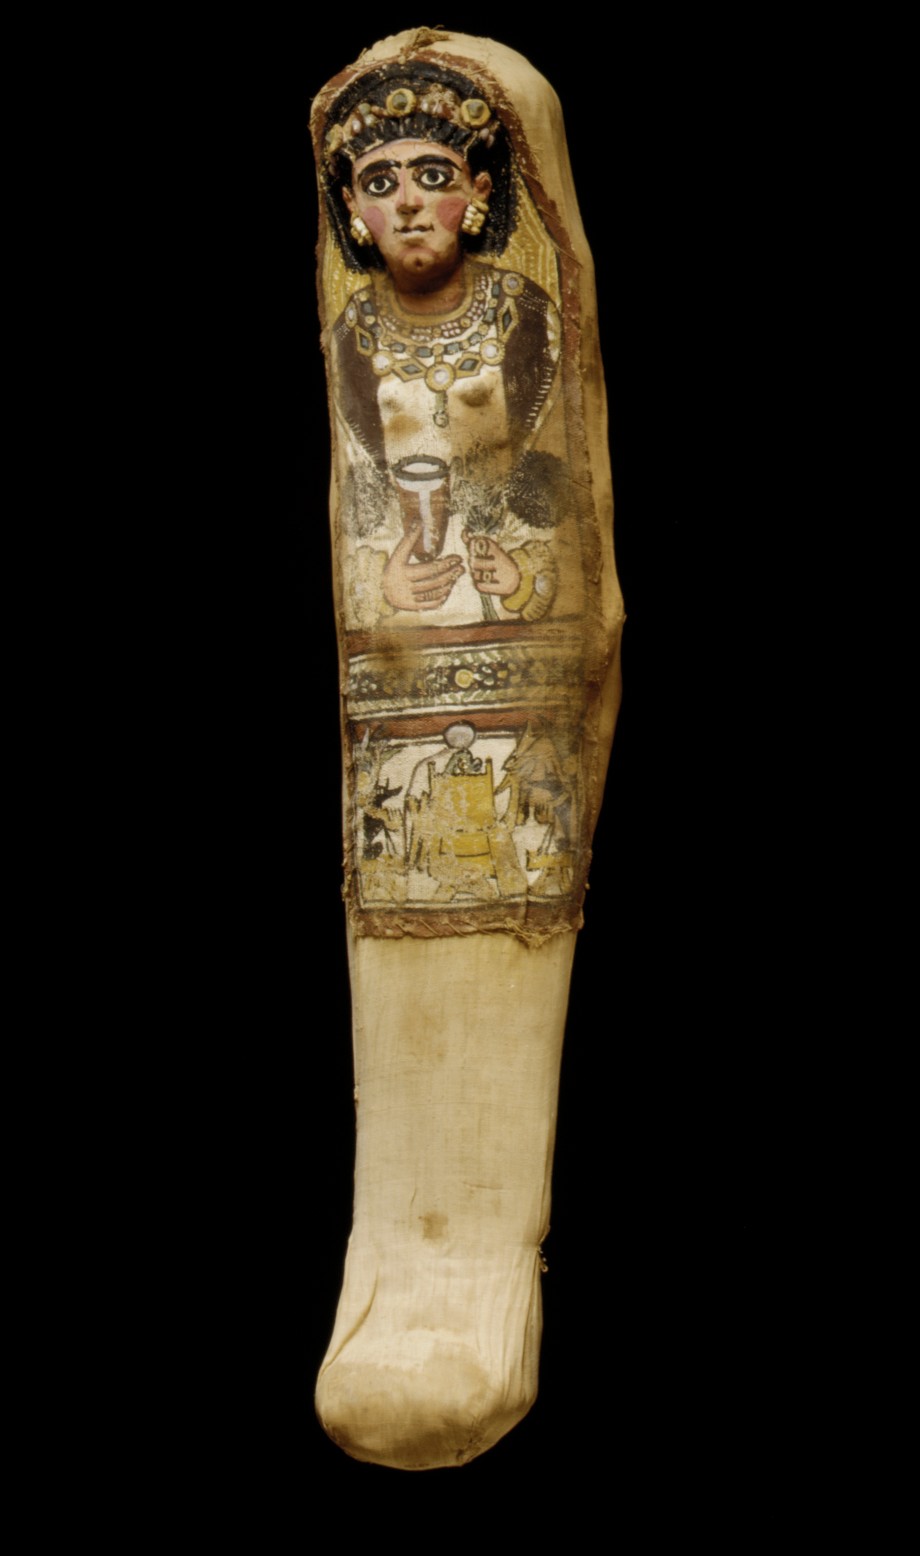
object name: mummy, woman, mask of plaster and paint, human remains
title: Mummy with a Painted Mask Depicting a Woman Holding a Goblet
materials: linen, paint, plaster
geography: egypt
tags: women,mummies